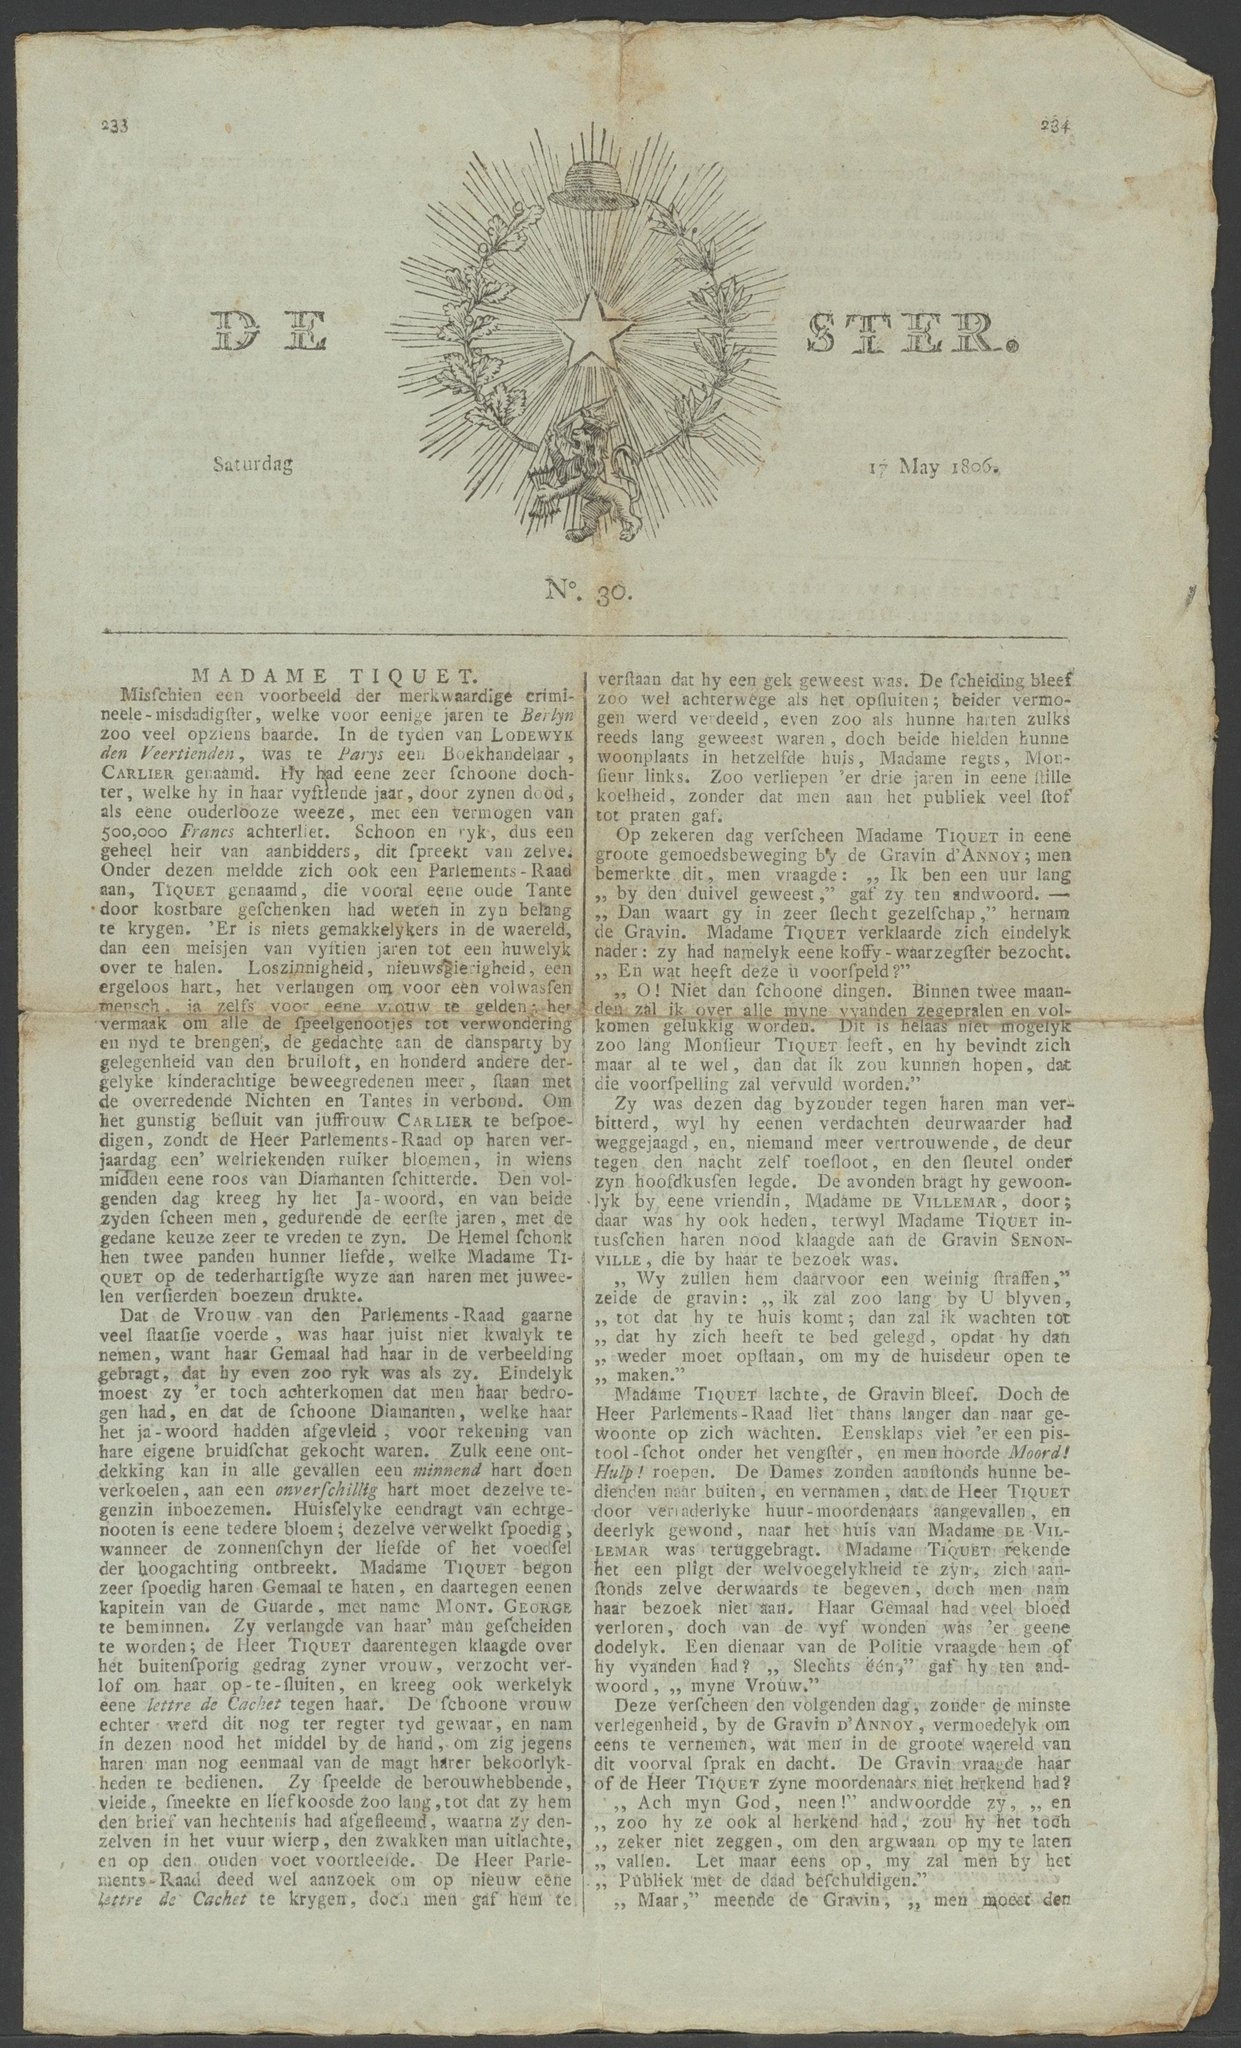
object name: newspaper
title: De Ster, 17 mei 1806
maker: j.g. rohloff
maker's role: printer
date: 1806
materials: paper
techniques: letterpress printing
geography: amsterdam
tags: newspaper, news-sheet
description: Exemplaar van de krant 'De Ster' van 17 mei 1806, nr. 30. Dubbelbladig, alle zijden bedrukt. De kolommen genummerd 233-240. Bovenaan een vignet met een stralende ster. Onderwerpsrubrieken binnen de Atlas Zeden en Gewoonten: Regeering, Officieele Nieuwsbladen.